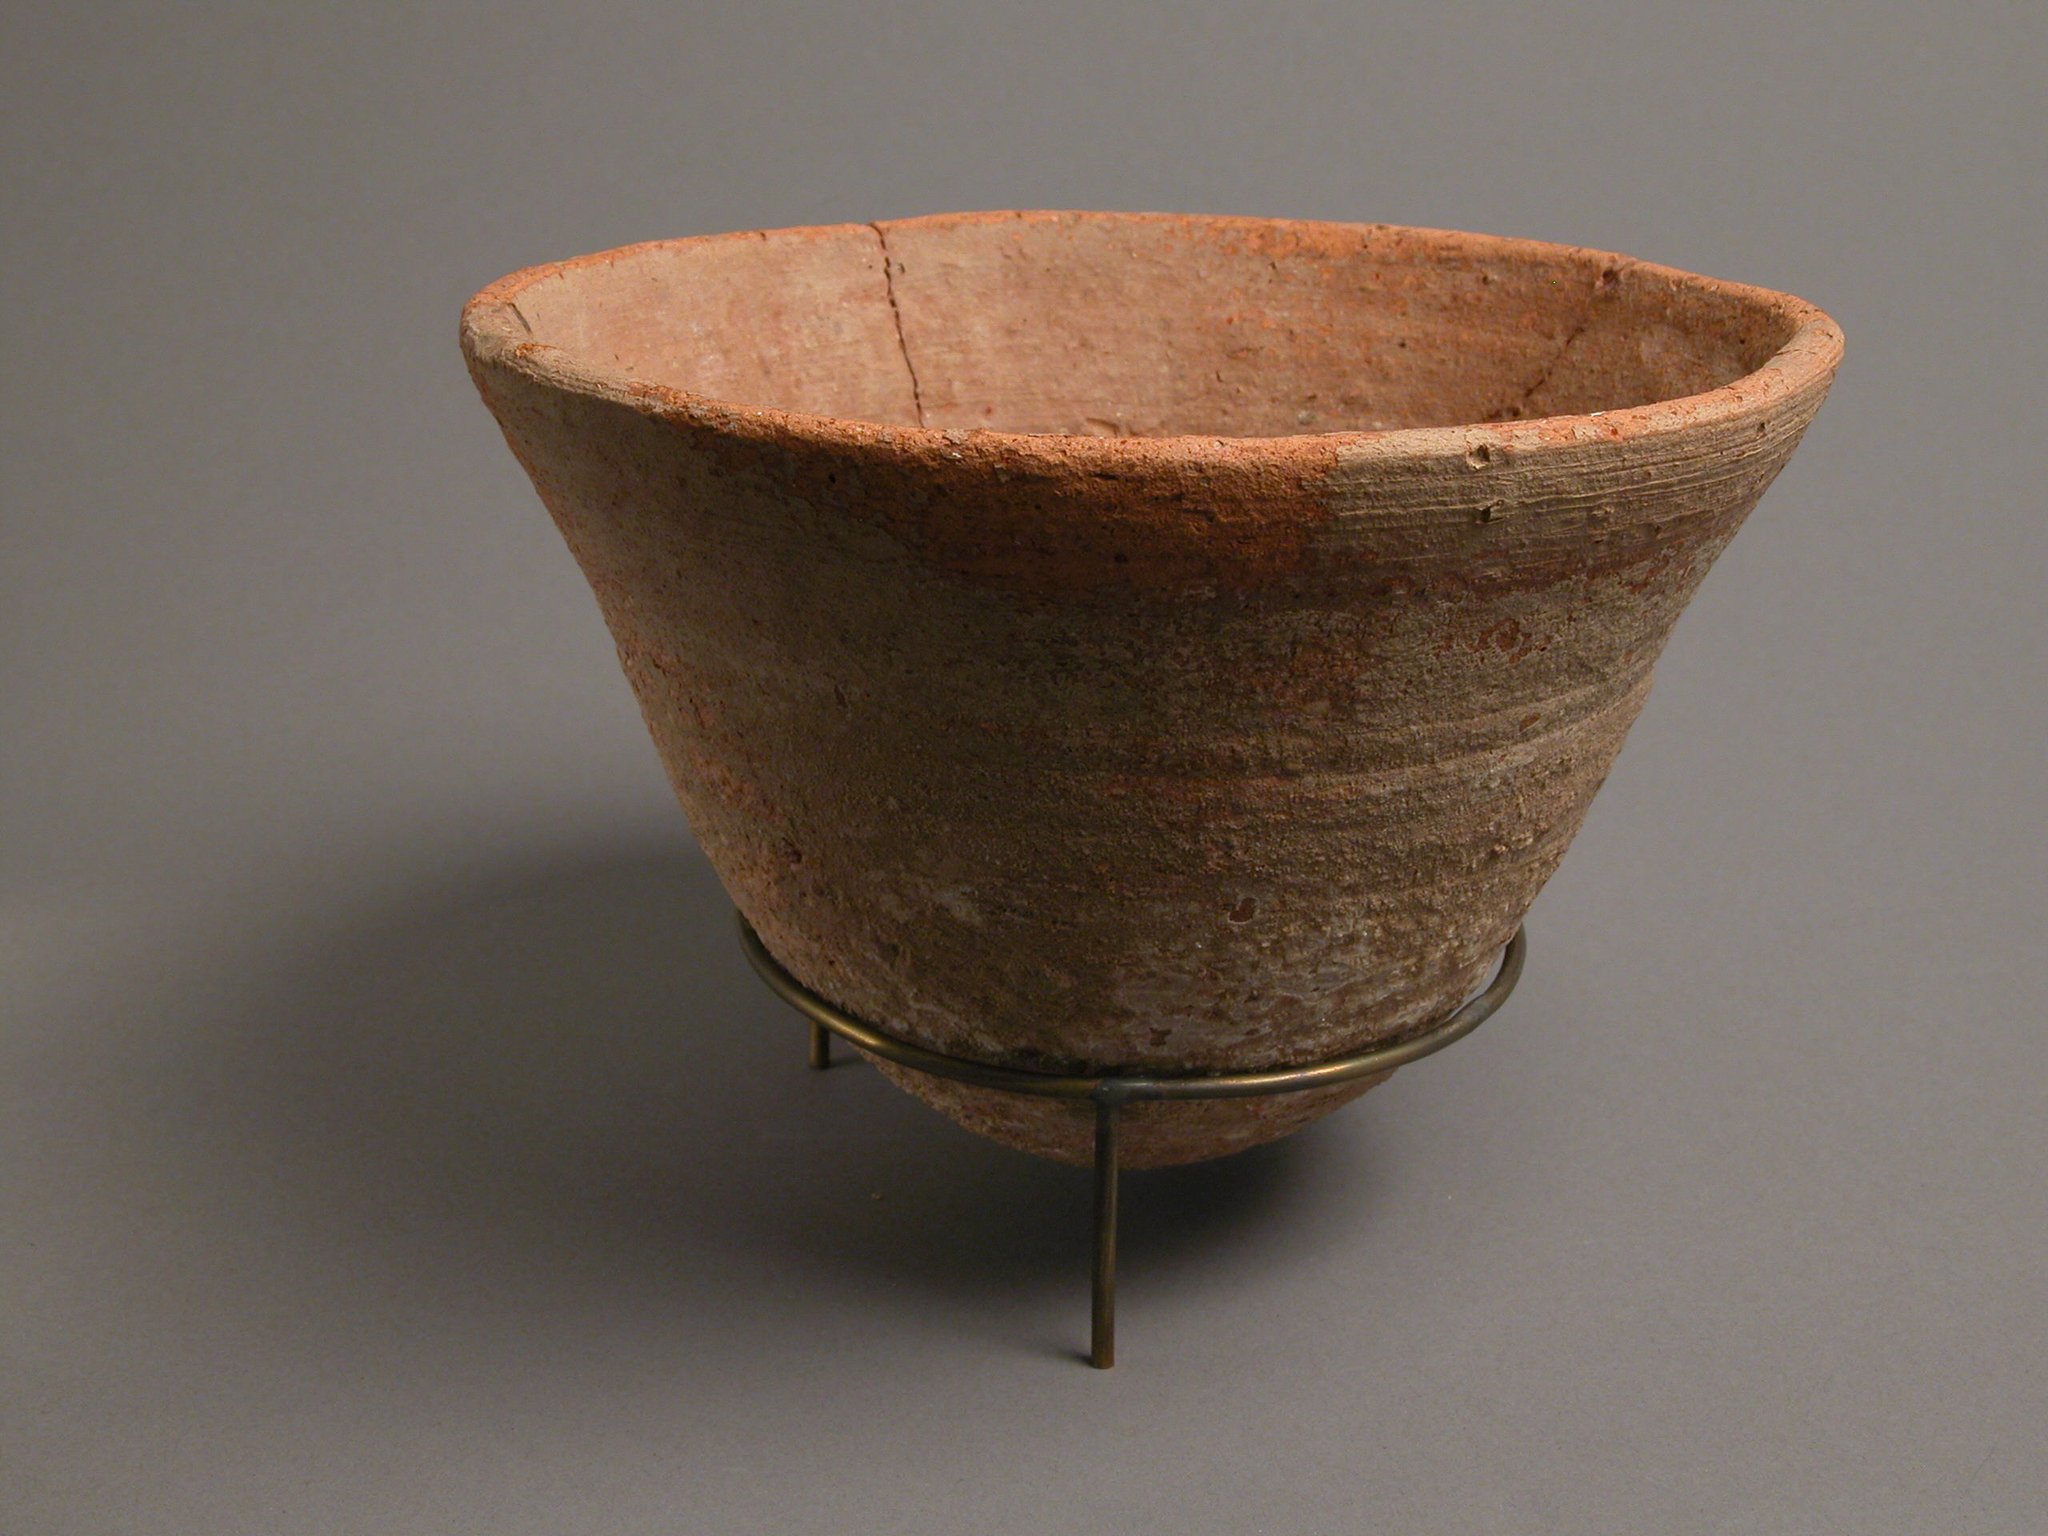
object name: bowl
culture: coptic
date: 301-700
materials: earthenware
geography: egypt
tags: bowls